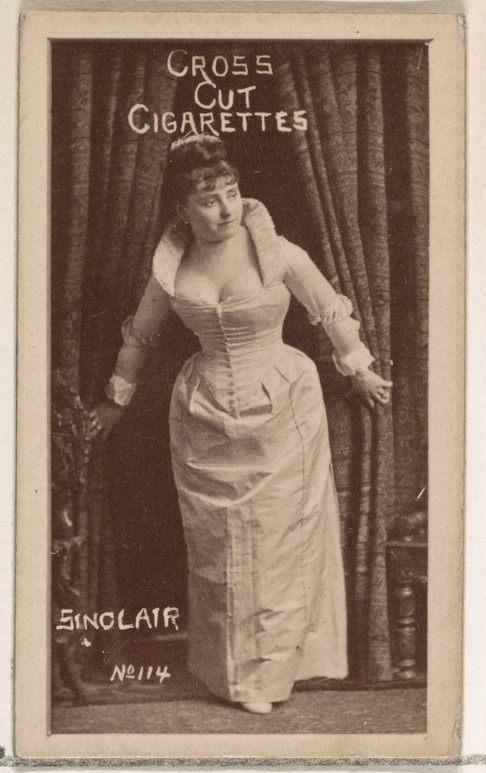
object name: print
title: Card Number 114, Sinclair, from the Actors and Actresses series (N145-1) issued by Duke Sons & Co. to promote Cross Cut Cigarettes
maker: w. duke, sons & co.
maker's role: publisher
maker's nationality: american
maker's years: 1870-1920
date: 1880-1889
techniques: albumen silver print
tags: portraits,women,actresses